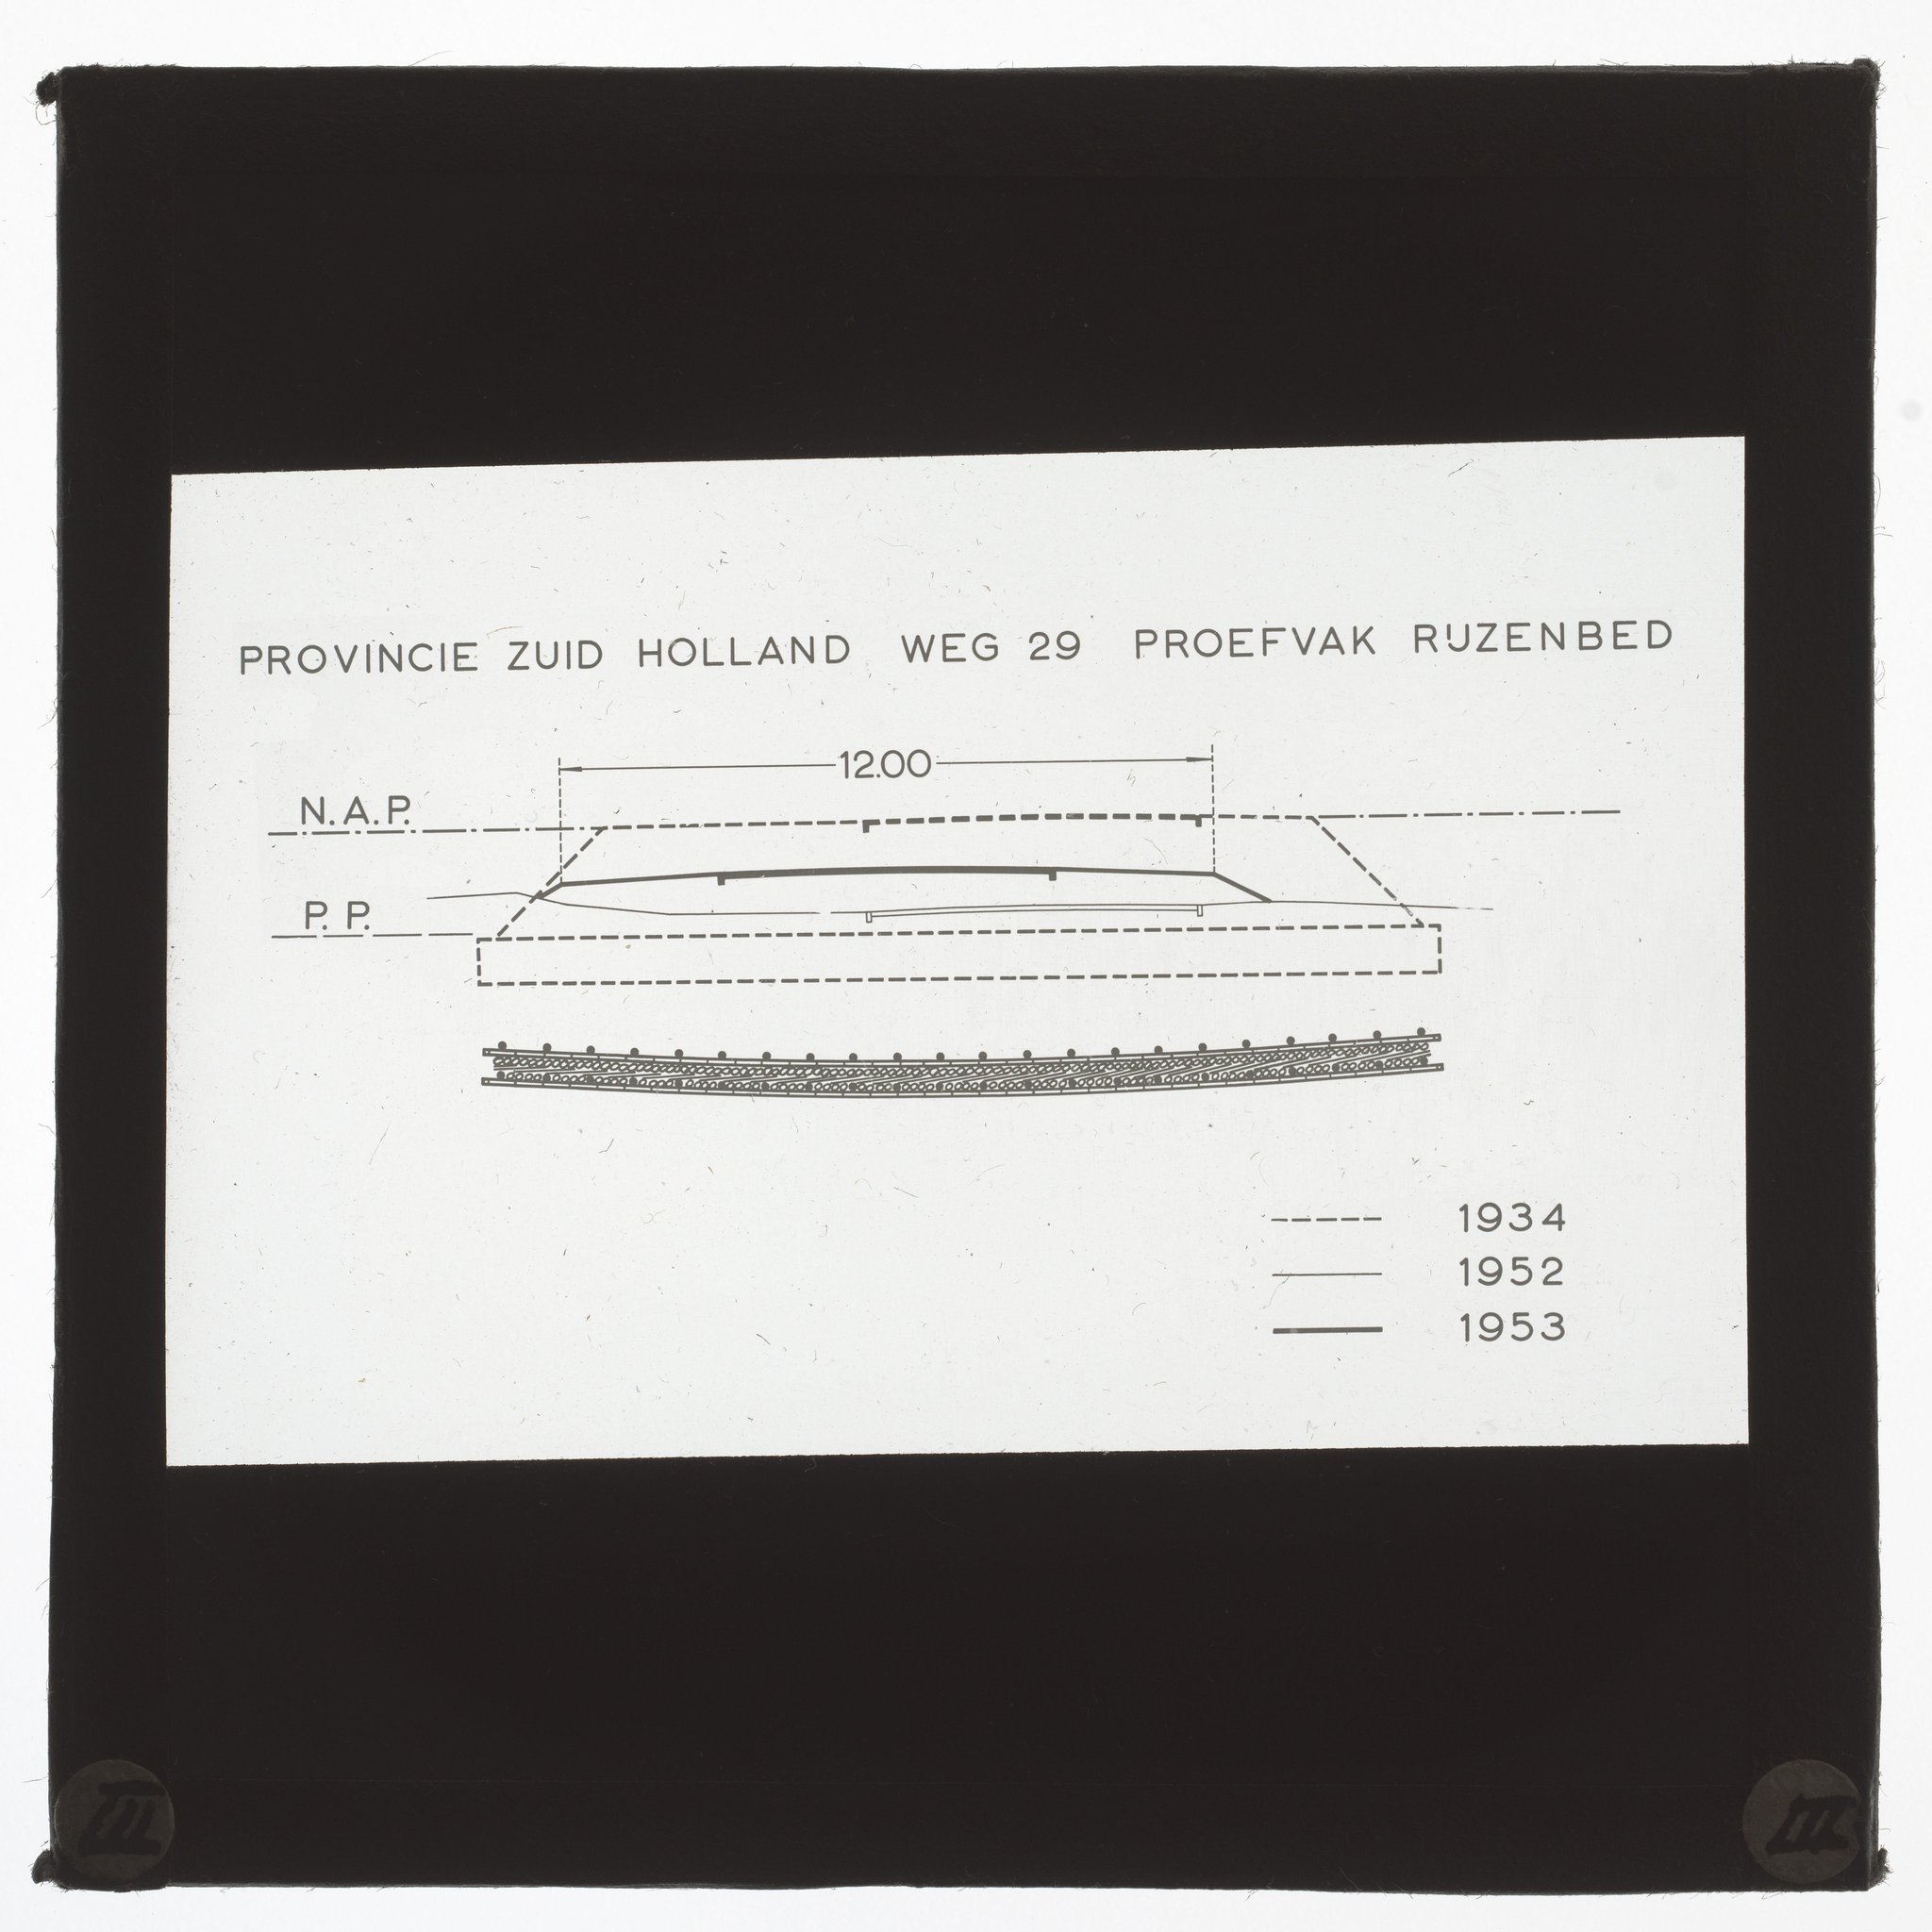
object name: lantern slide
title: Dwarsdoorsnede van een provinciale weg in Zuid-Holland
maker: Anonymous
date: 1956-1960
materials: glass, paper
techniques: printing block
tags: statistic diagram, graph; pictorial chart, etc., public road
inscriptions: number: ‘III’